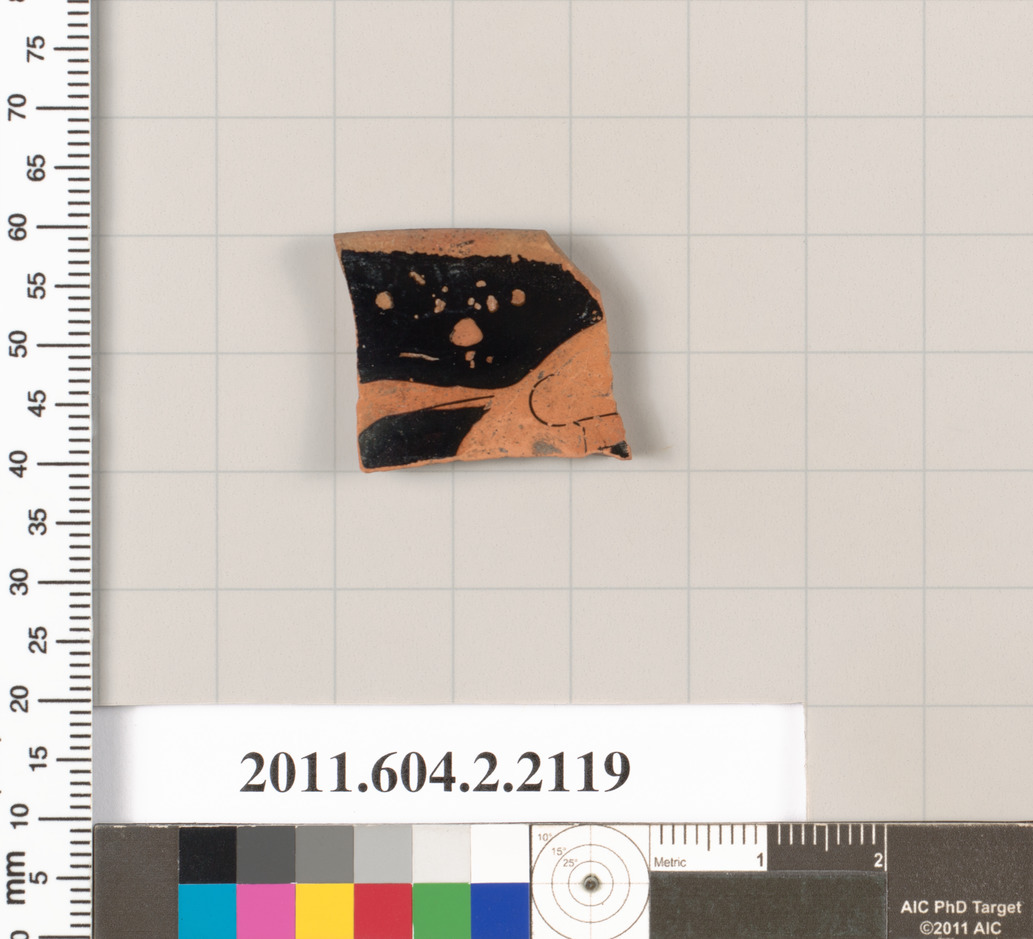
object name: rhyton fragment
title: Terracotta fragment of a rhyton (vase for libations and drinking)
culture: greek, attic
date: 460-450 BCE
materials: terracotta